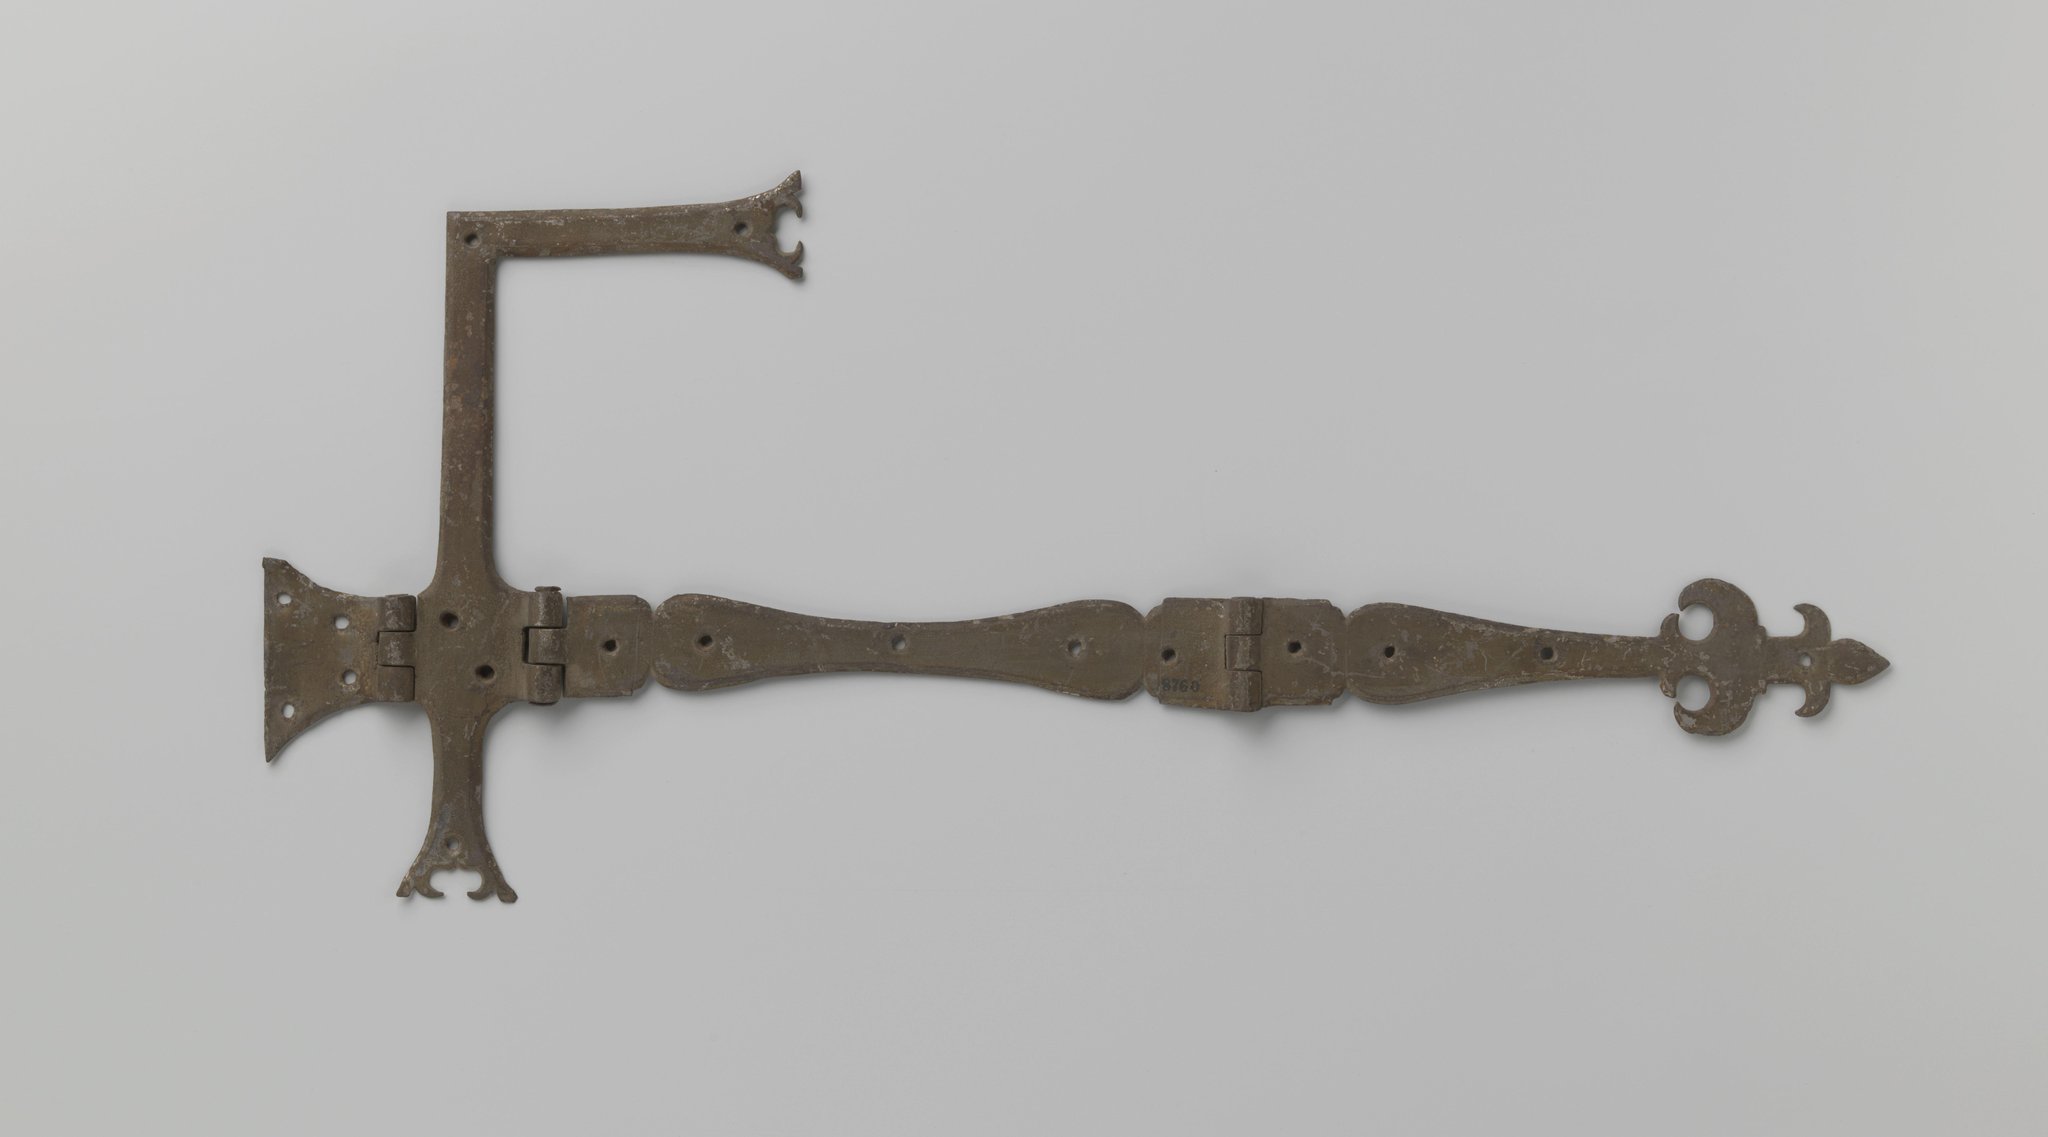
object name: scharnier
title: Beslag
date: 1400-1950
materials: iron